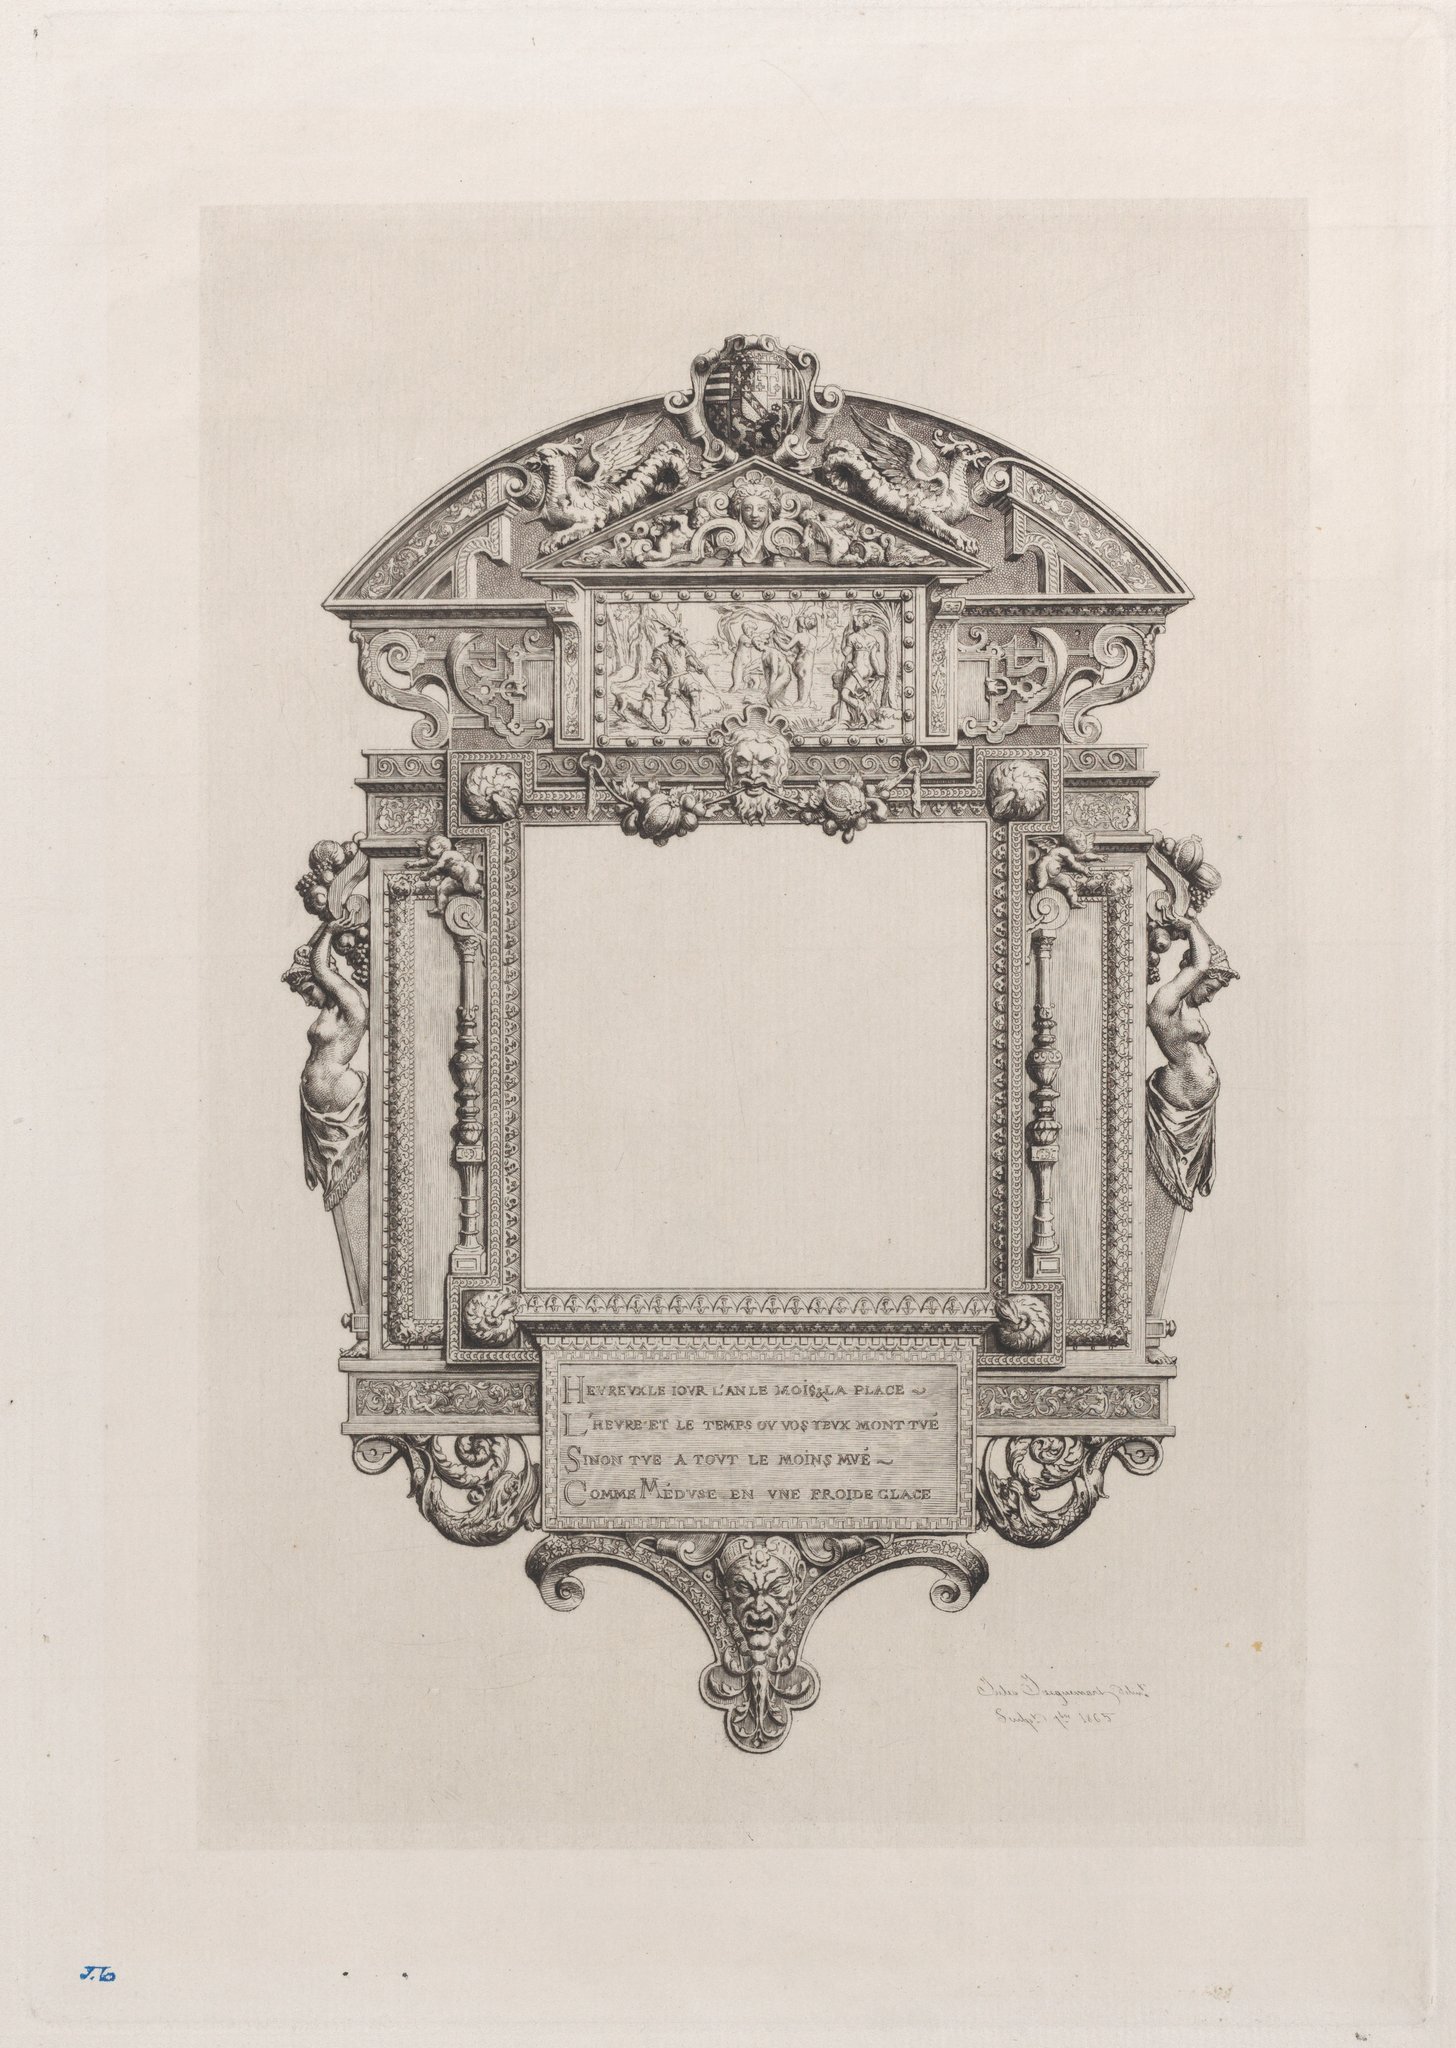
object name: print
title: French Mirror of the XVI Century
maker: jules-ferdinand jacquemart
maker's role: artist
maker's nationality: french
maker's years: 1837-1880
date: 1865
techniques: etching